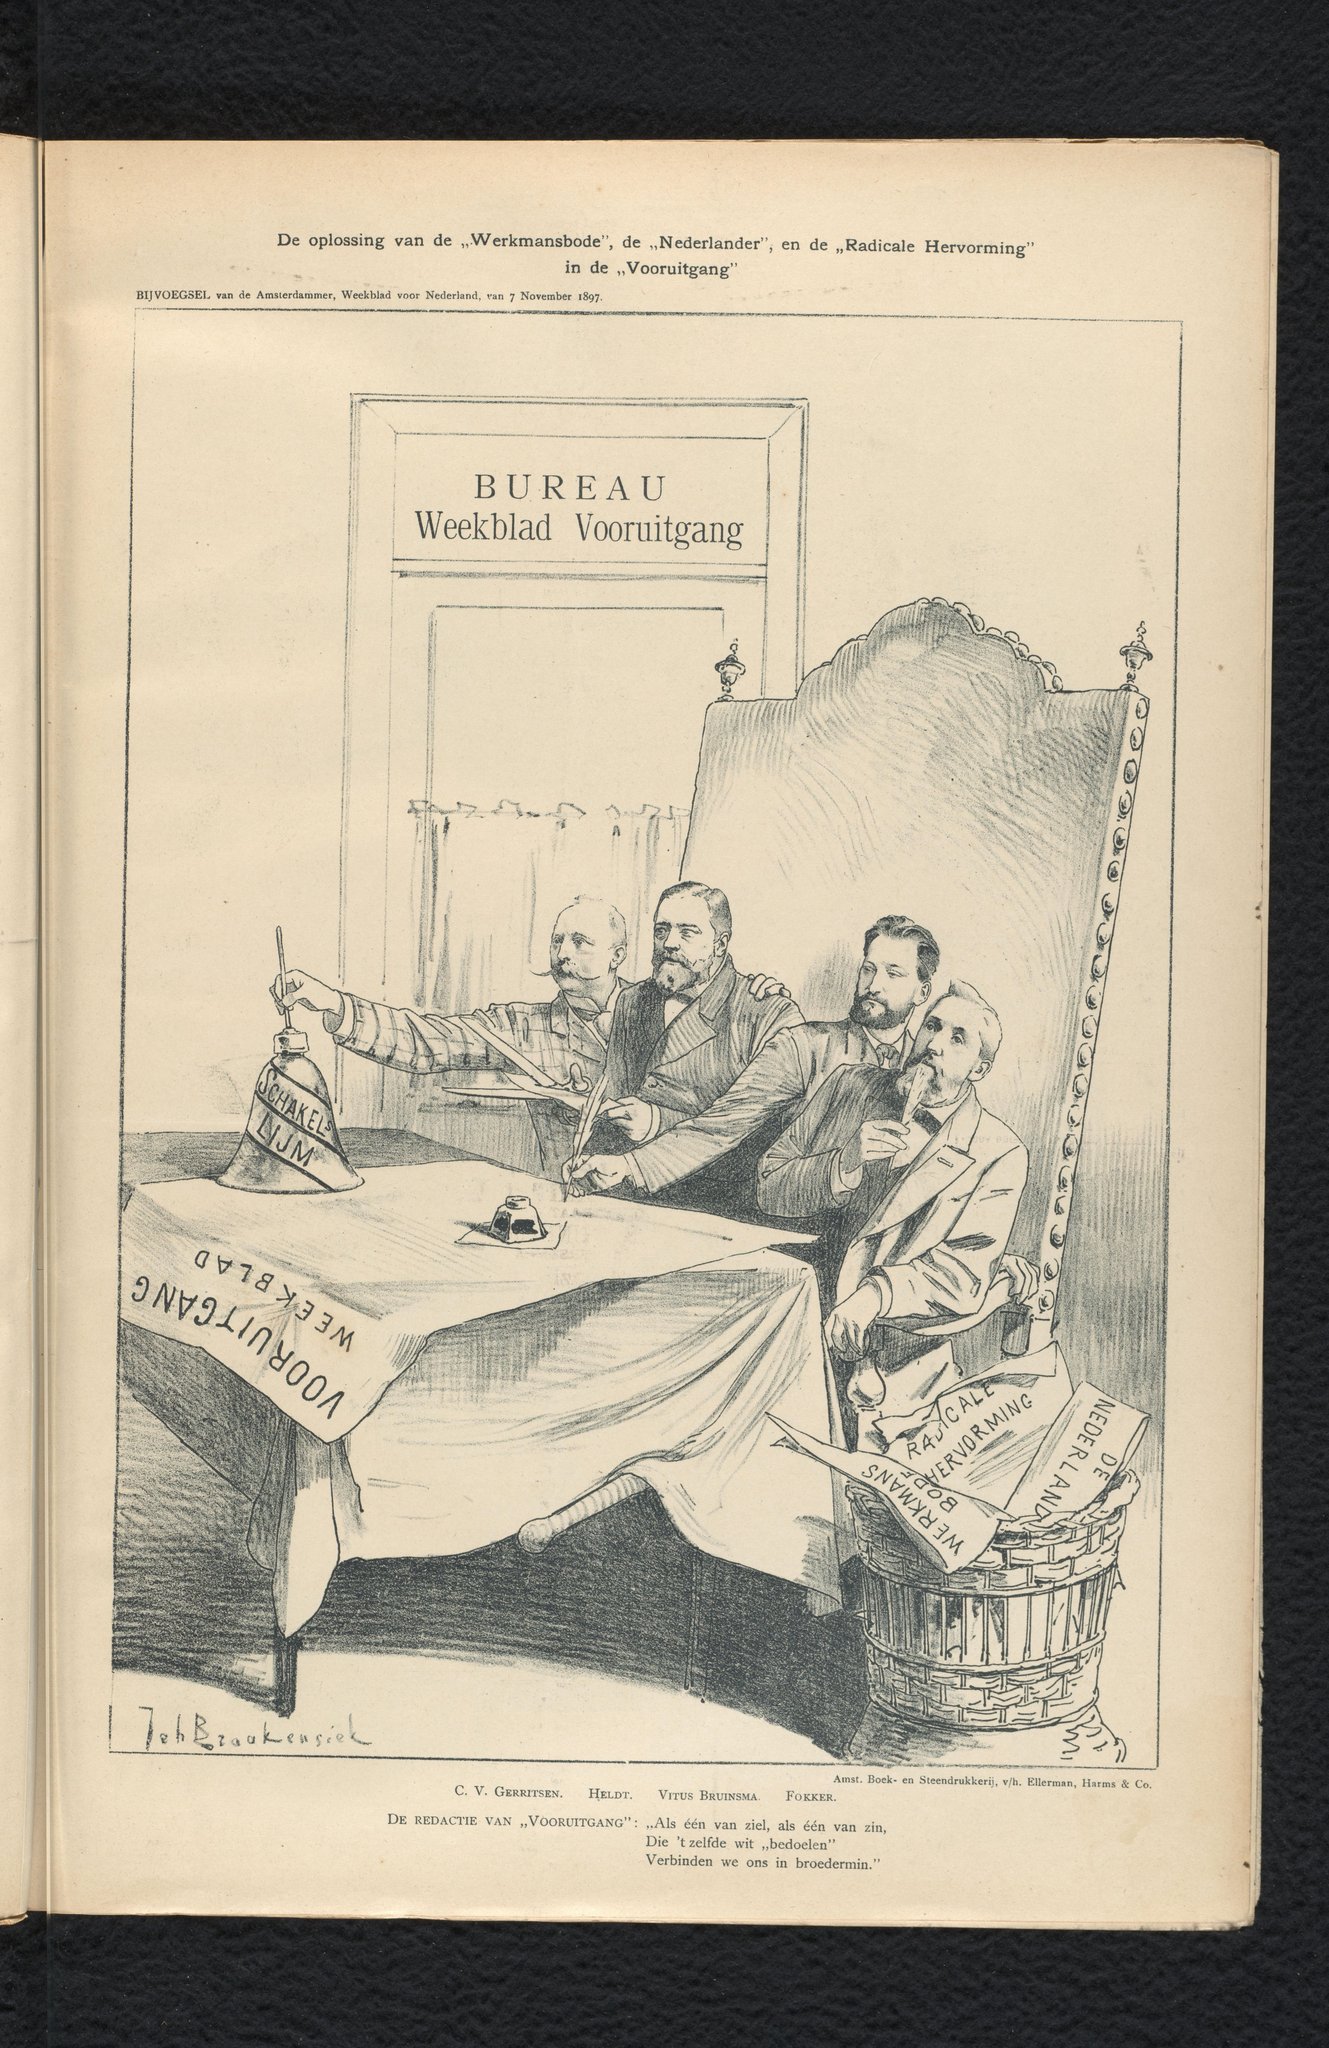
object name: cartoon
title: De oplossing van de "Werkmansbode", de "Nederlander", en de "Radicale Hervorming" in de "Vooruitgang"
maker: johan braakensiek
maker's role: draughtsman, print maker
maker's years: 1858-1940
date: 1897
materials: paper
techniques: lithograph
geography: netherlands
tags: politician, rotterdam, the hague, amsterdam, arnhem, furniture worker, journalist, reporter, newspaper, news-sheet, political caricatures and satires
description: De vier redacteuren Gerritsen, Heldt, Bruinsma en Fokker samen op de stoel van de redactie van het weekblad Vooruitgang.